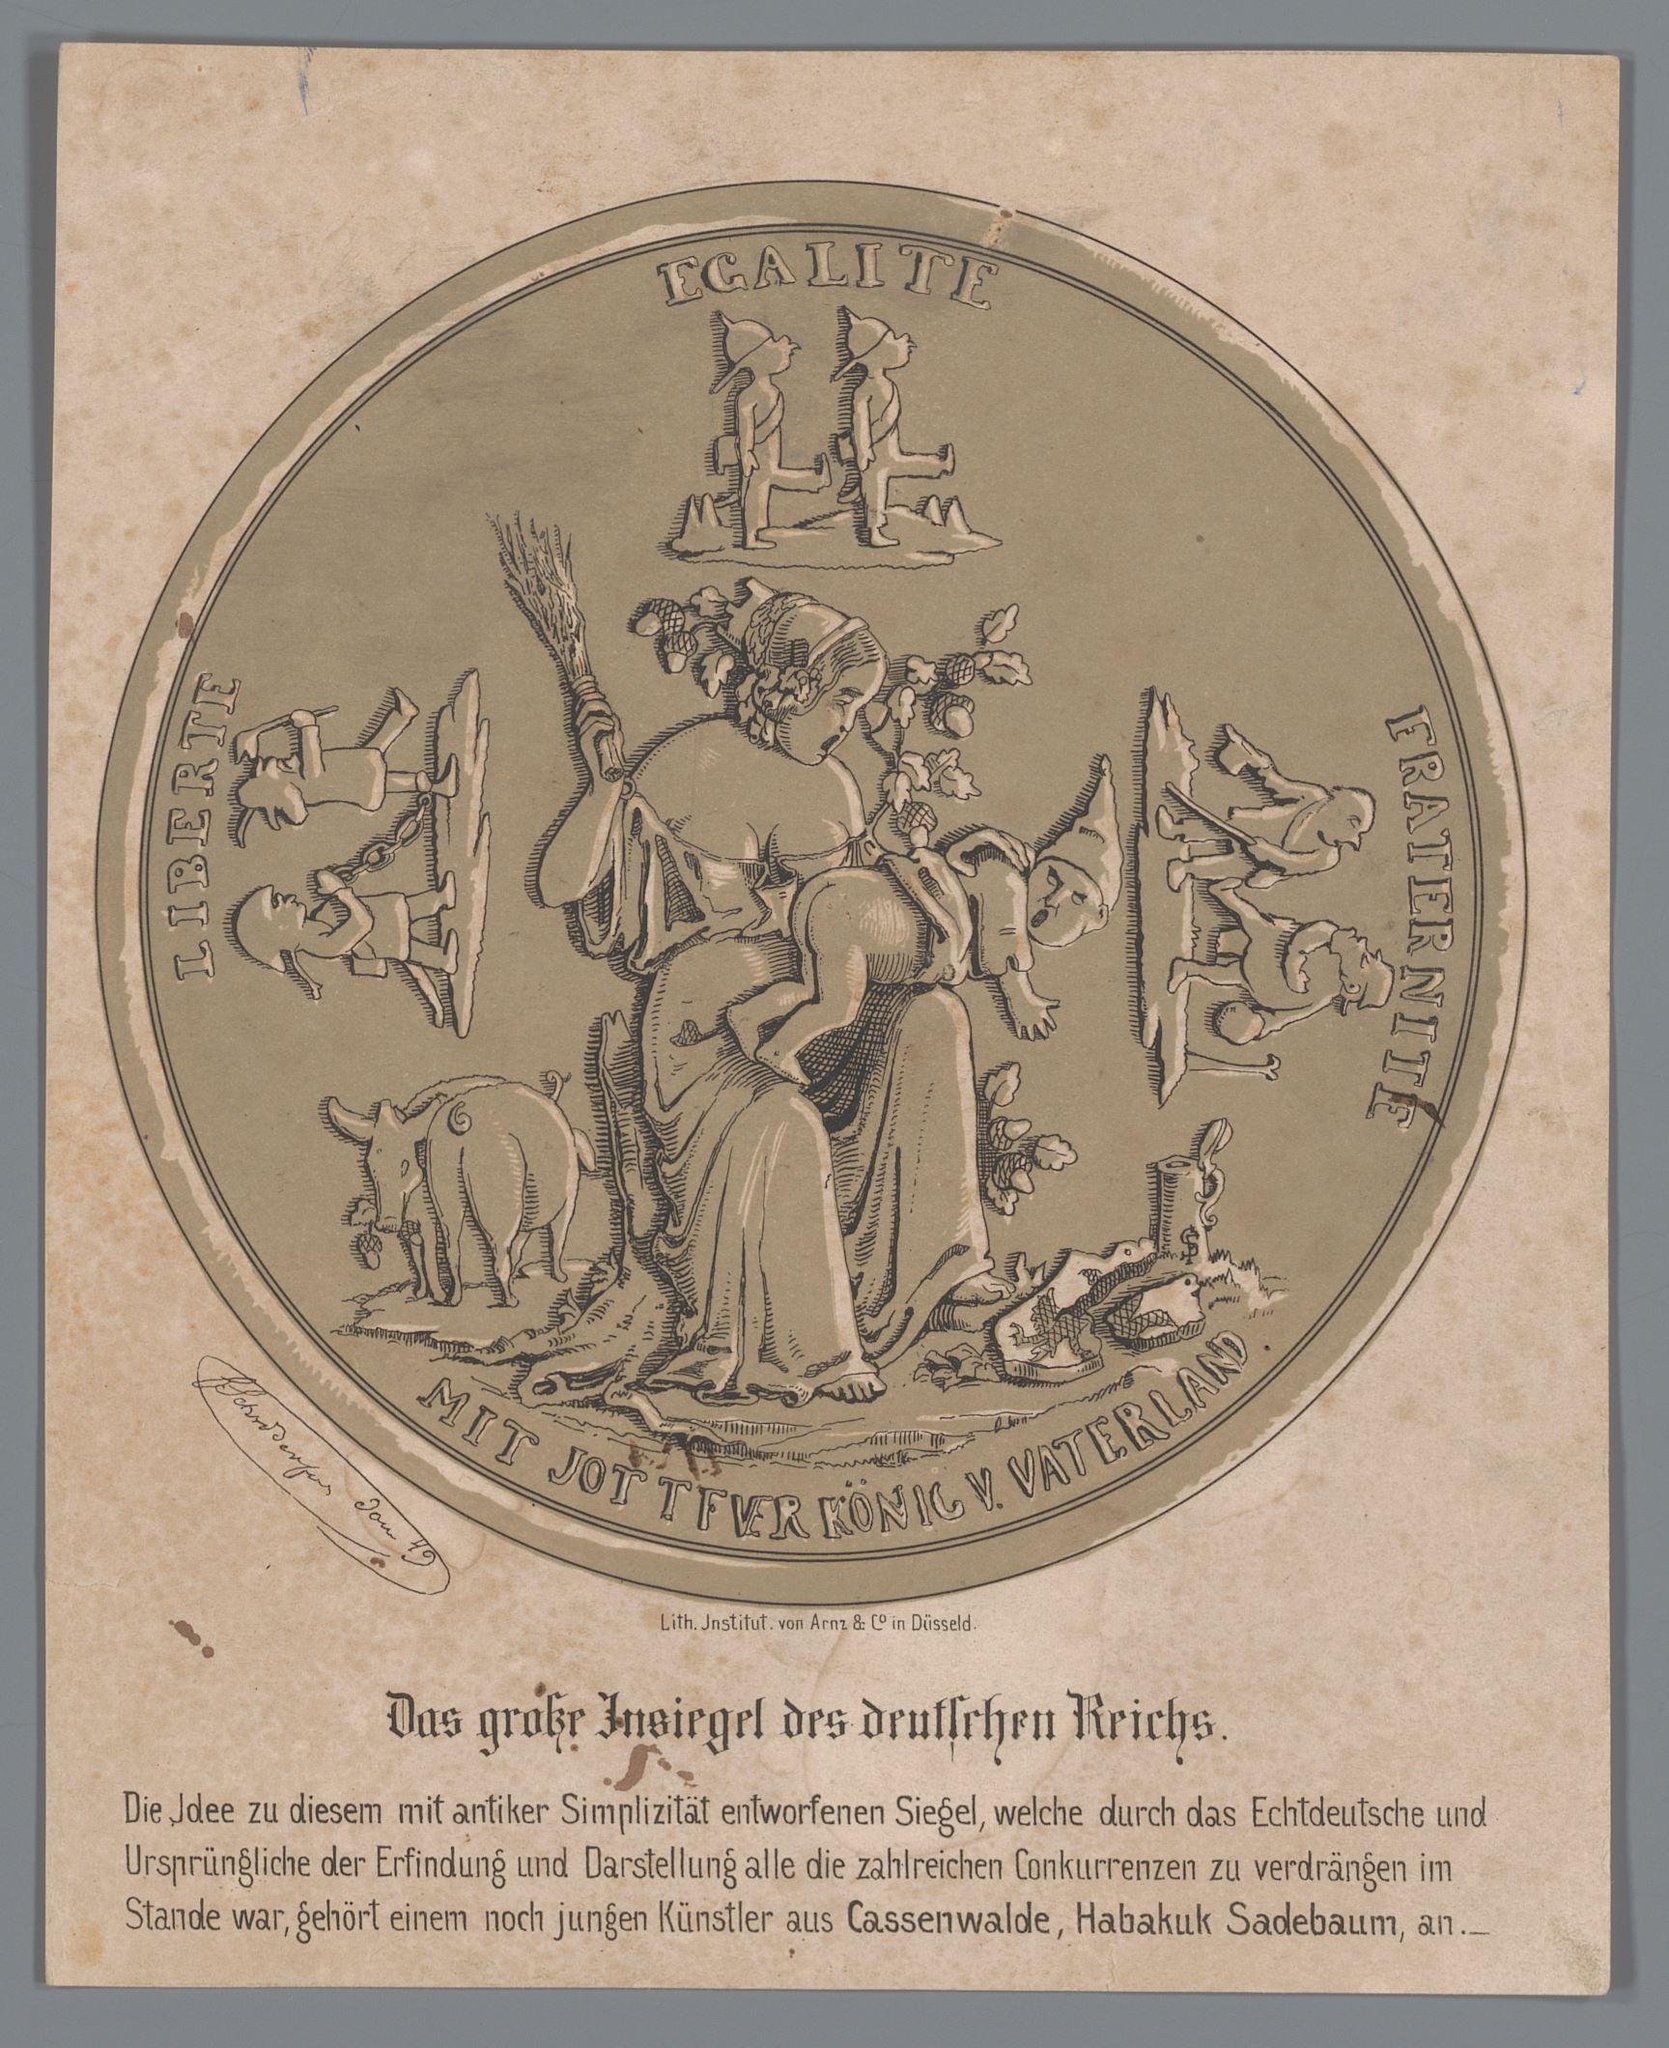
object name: cartoon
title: Kind met Frygische muts wordt geslagen door een vrouw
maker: Anonymous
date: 1849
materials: paper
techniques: lithograph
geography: dusseldorf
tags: city-crown, mural crown, phrygian bonnet, political caricatures and satires, fruits: acorn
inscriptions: collector's mark: Lugt 2228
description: Spotprent, mogelijk op de Maartrevolutie en het Duitse Rijk van 1848-1849. Munt met centraal een voorstelling van een vrouw met een stedenkroon met eikels en een bos koren in de hand, waarmee ze een kind op haar schoot op de billen slaat. Dit kind heeft een Frygische muts op, symbool van de vrijheid tijdens de Franse revolutie. Naast hen ligt een gebroken wapenschild met de Napoleontische, of de Duitse adelaar. Rondom deze voorstelling de woorden Liberté, Égalité en Fraternité. Onder Liberté een voorstelling van een man die geketend voor een ander loopt. Onder Egalité twee marcherende soldaten. Onder Fraternité een man die op het punt staat een andere man te slaan. Onder de afbeelding een onderschrift in het Duits.